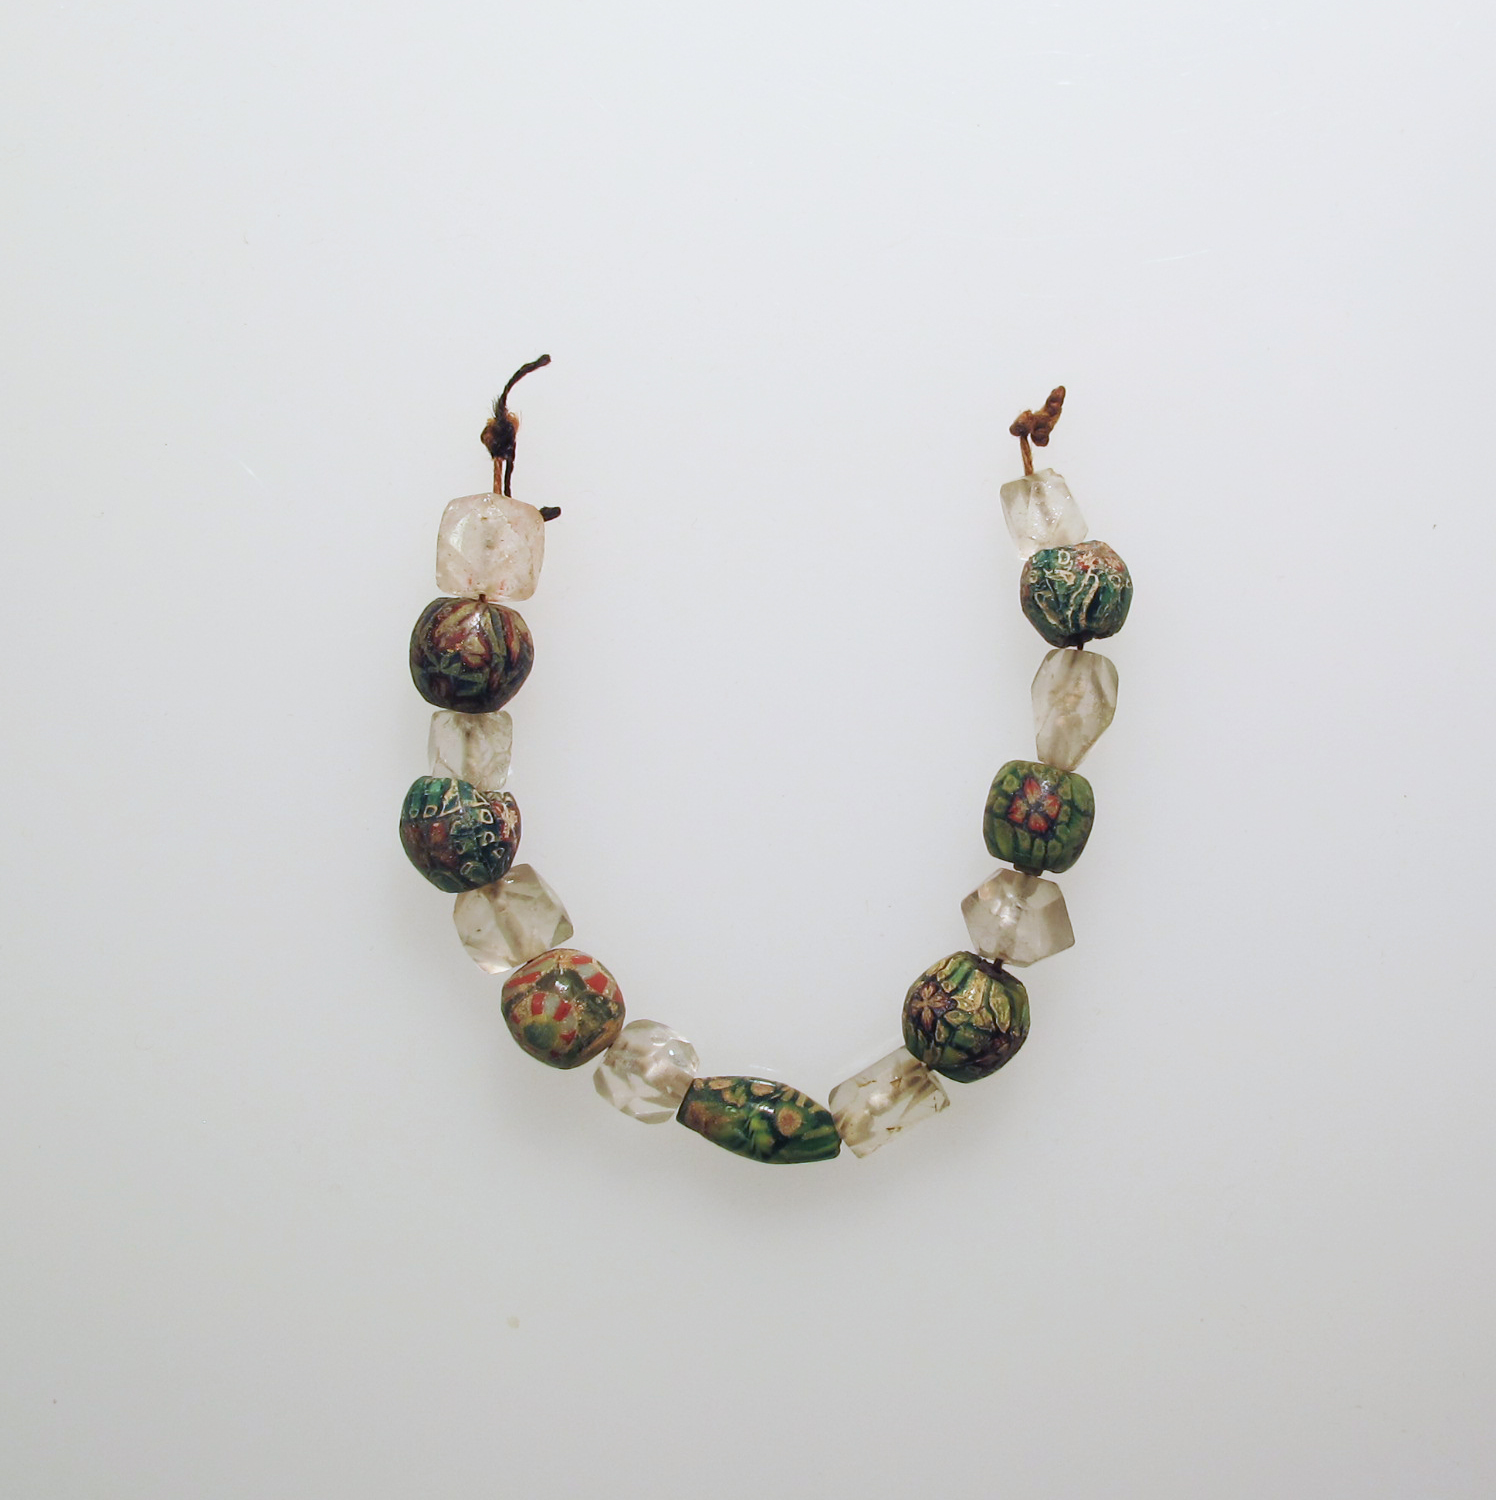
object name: bead 15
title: Glass and rock crystal beads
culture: roman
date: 1-200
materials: glass, quartz